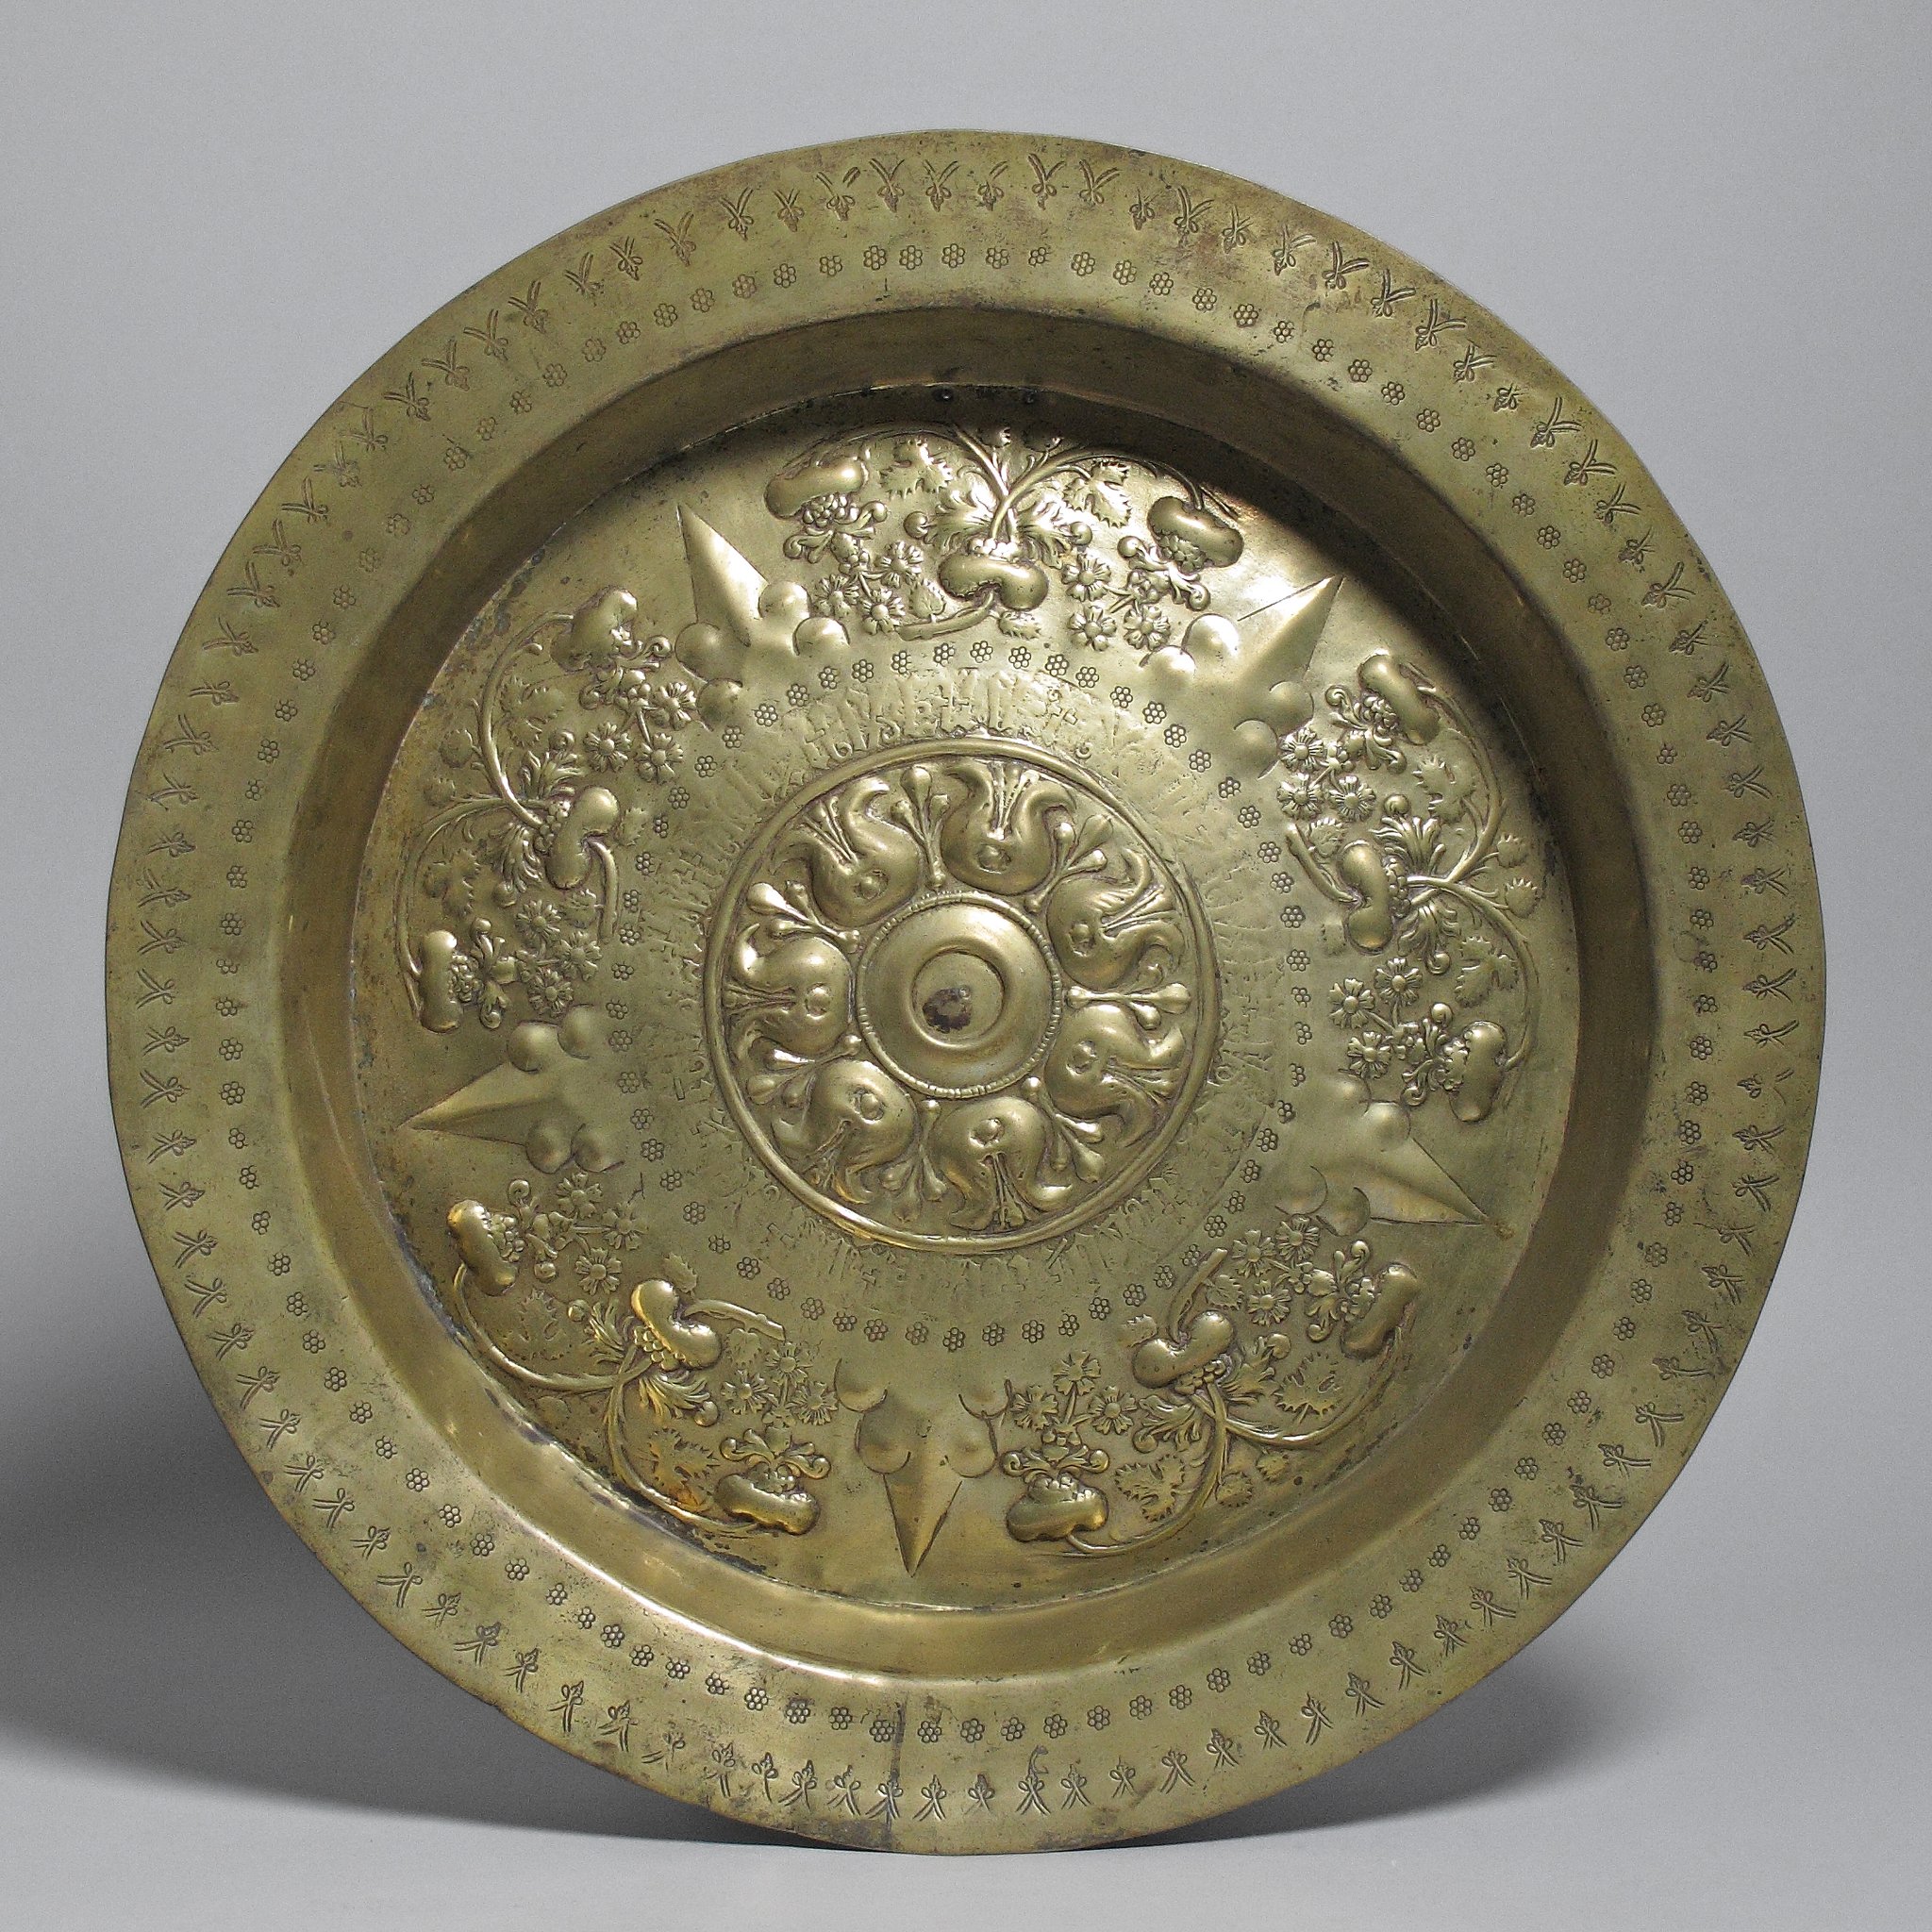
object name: plate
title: Charger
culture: german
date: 1475-1500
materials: copper alloy